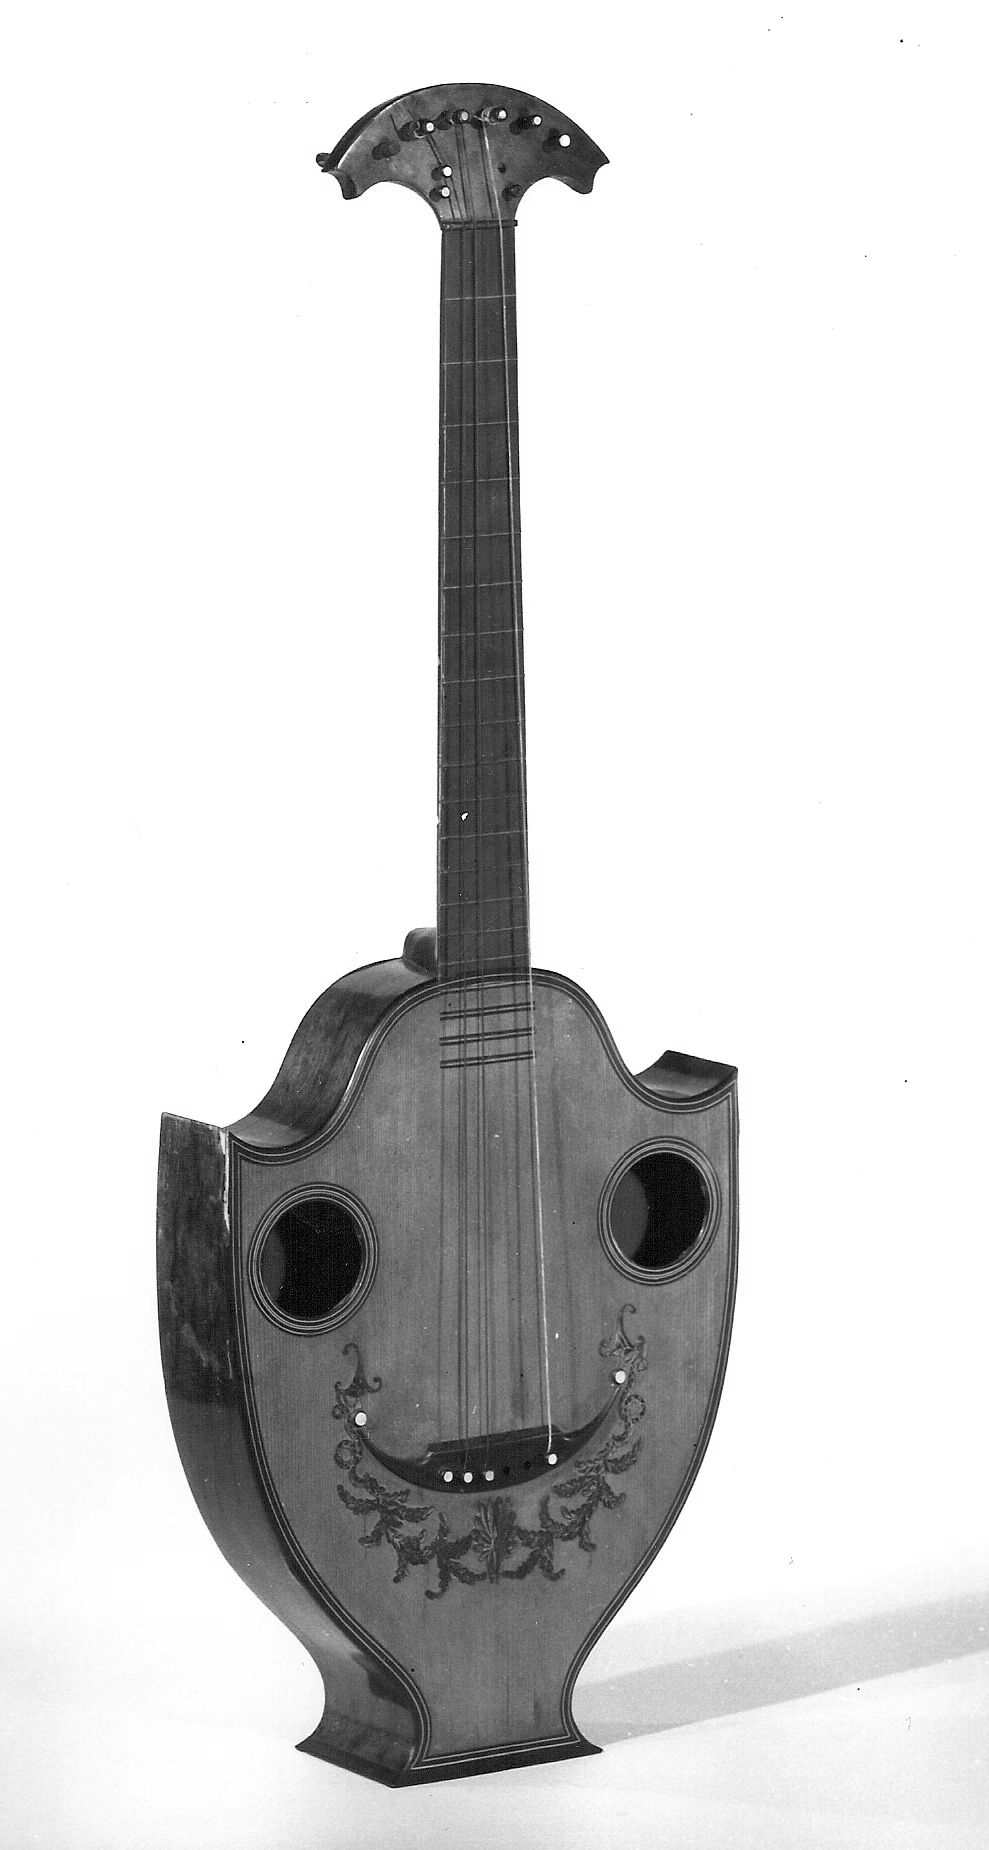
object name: lyre guitar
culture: french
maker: joseph-louis germain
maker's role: maker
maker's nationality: french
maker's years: 1822-1870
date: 1840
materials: metal, mother of pearl, silk, wood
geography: france